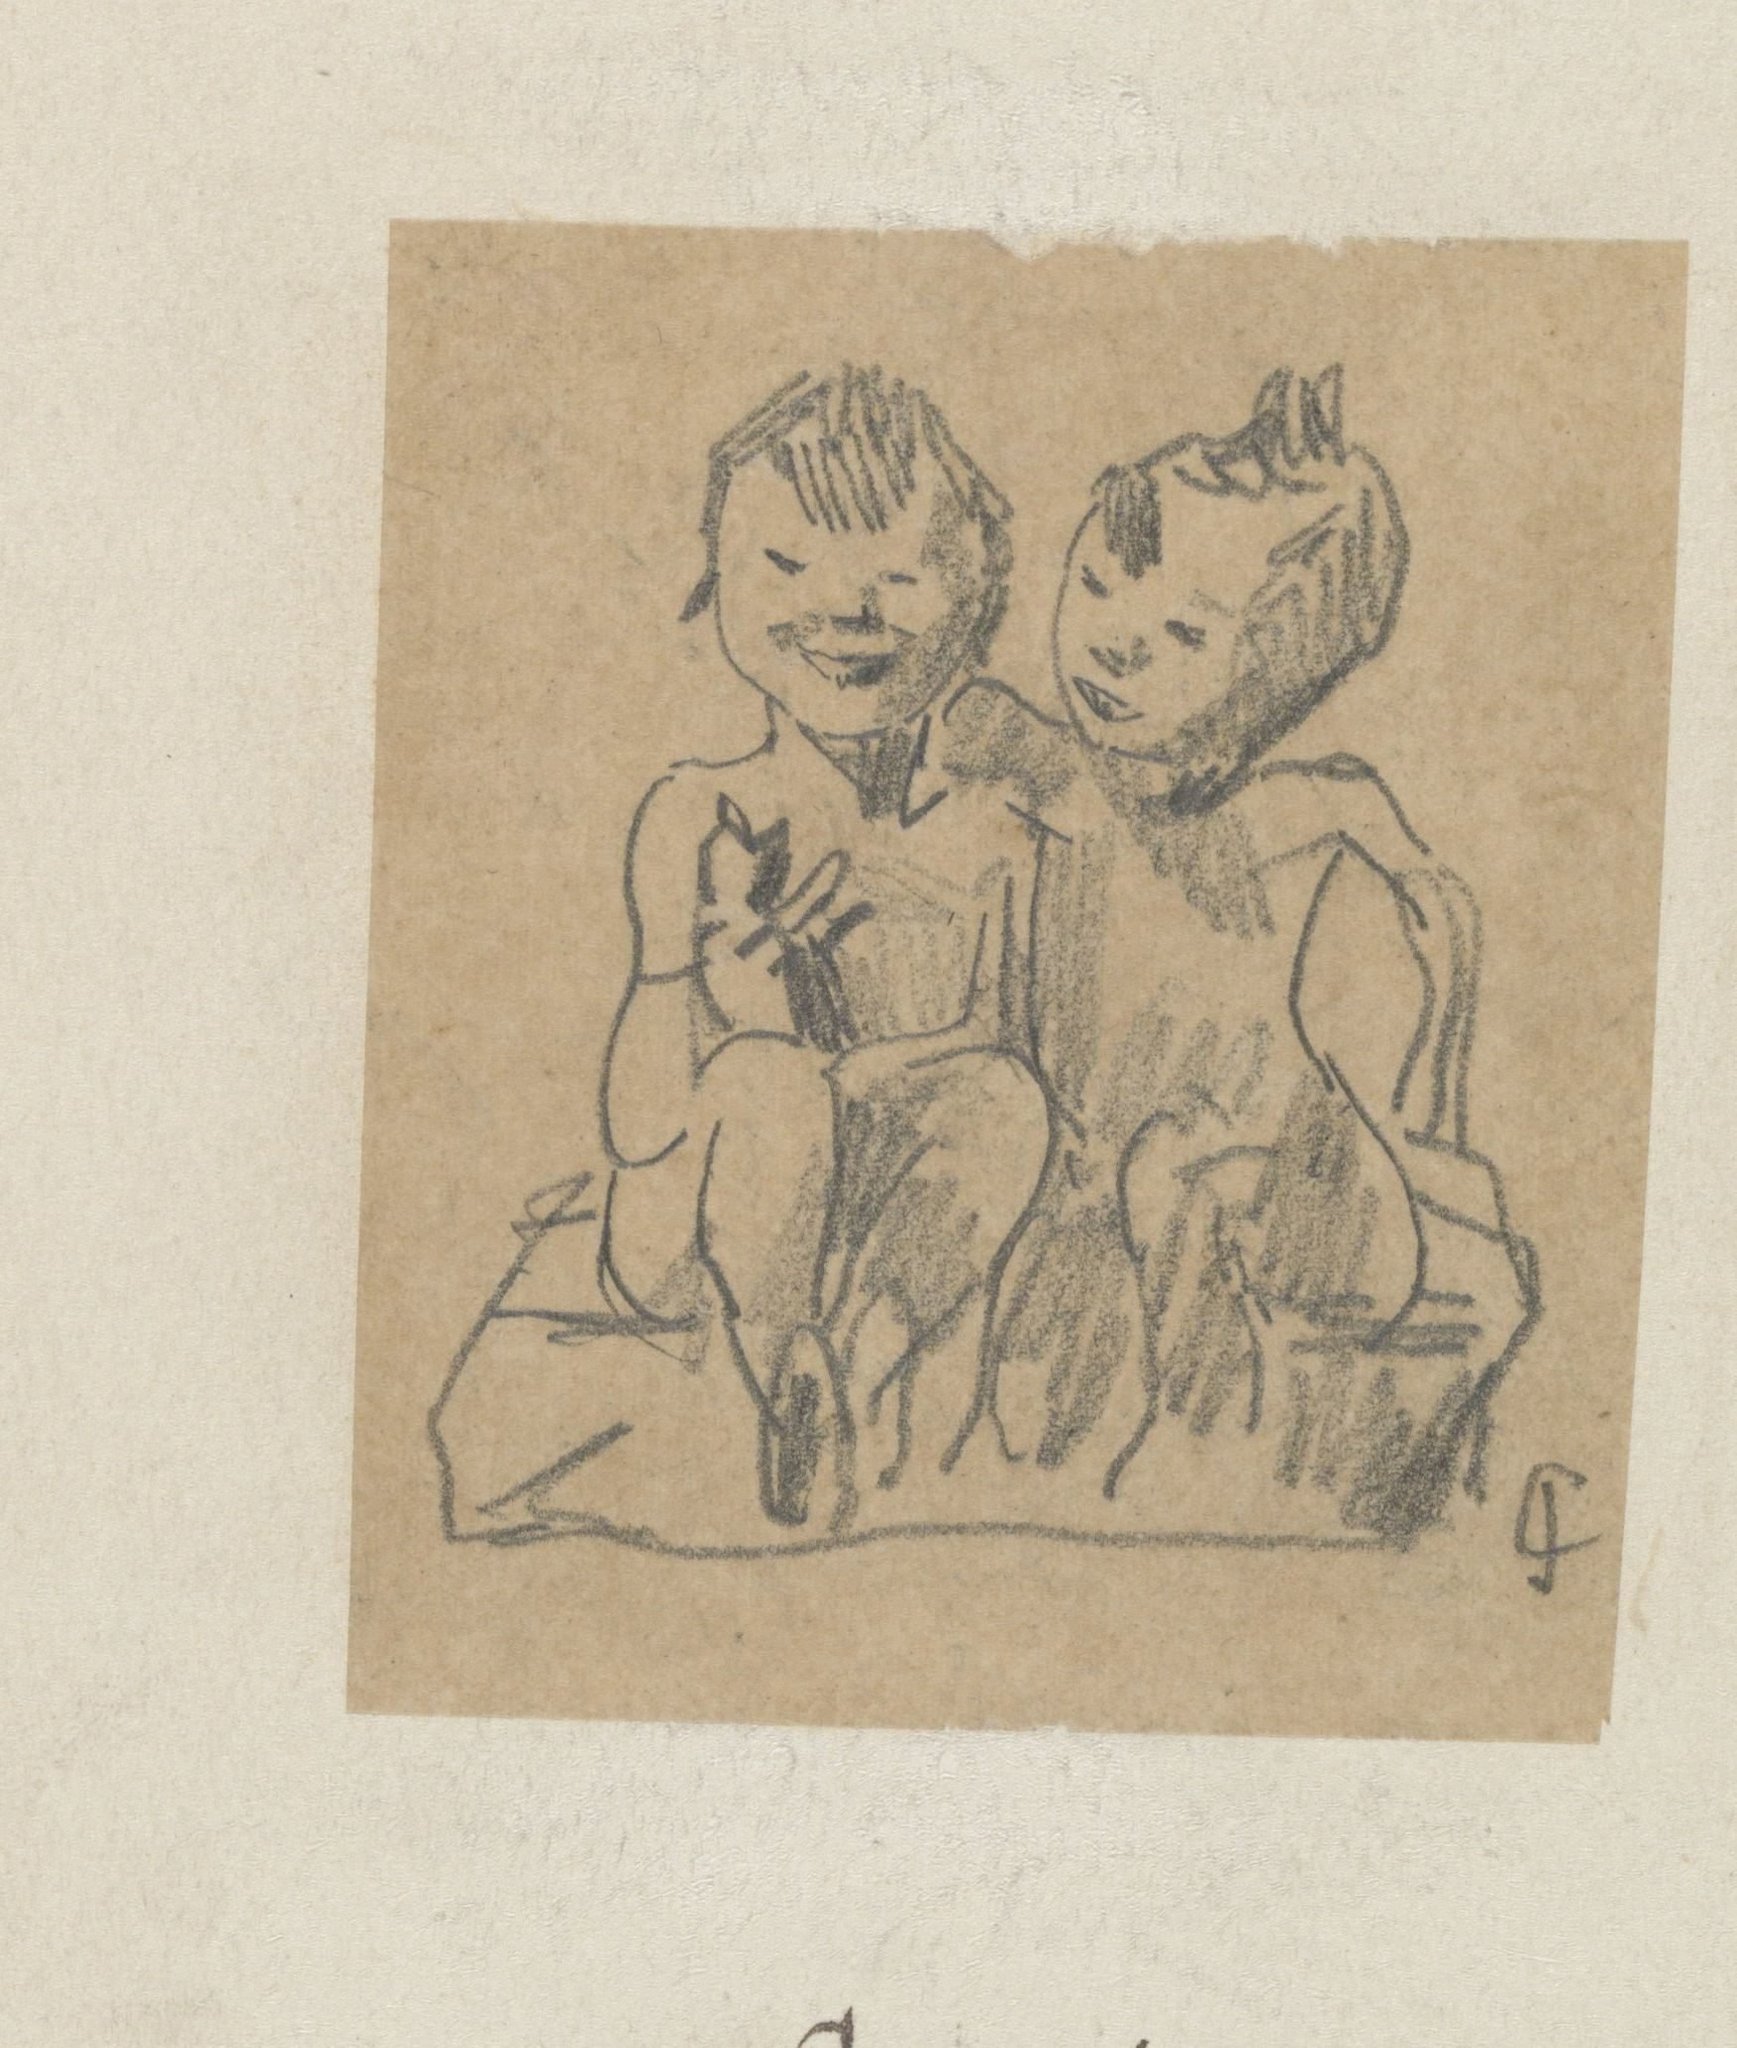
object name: design drawing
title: Twee kinderen met een pop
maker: gustave joseph chéret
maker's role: sculptor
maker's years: 1838-1894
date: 1870-1894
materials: cardboard, graphite, paper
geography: paris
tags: (playing with) dolls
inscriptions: monogram: ‘JC’, inscription: ‘Croquis’, workshop stamp: ‘Joseph Chéret’